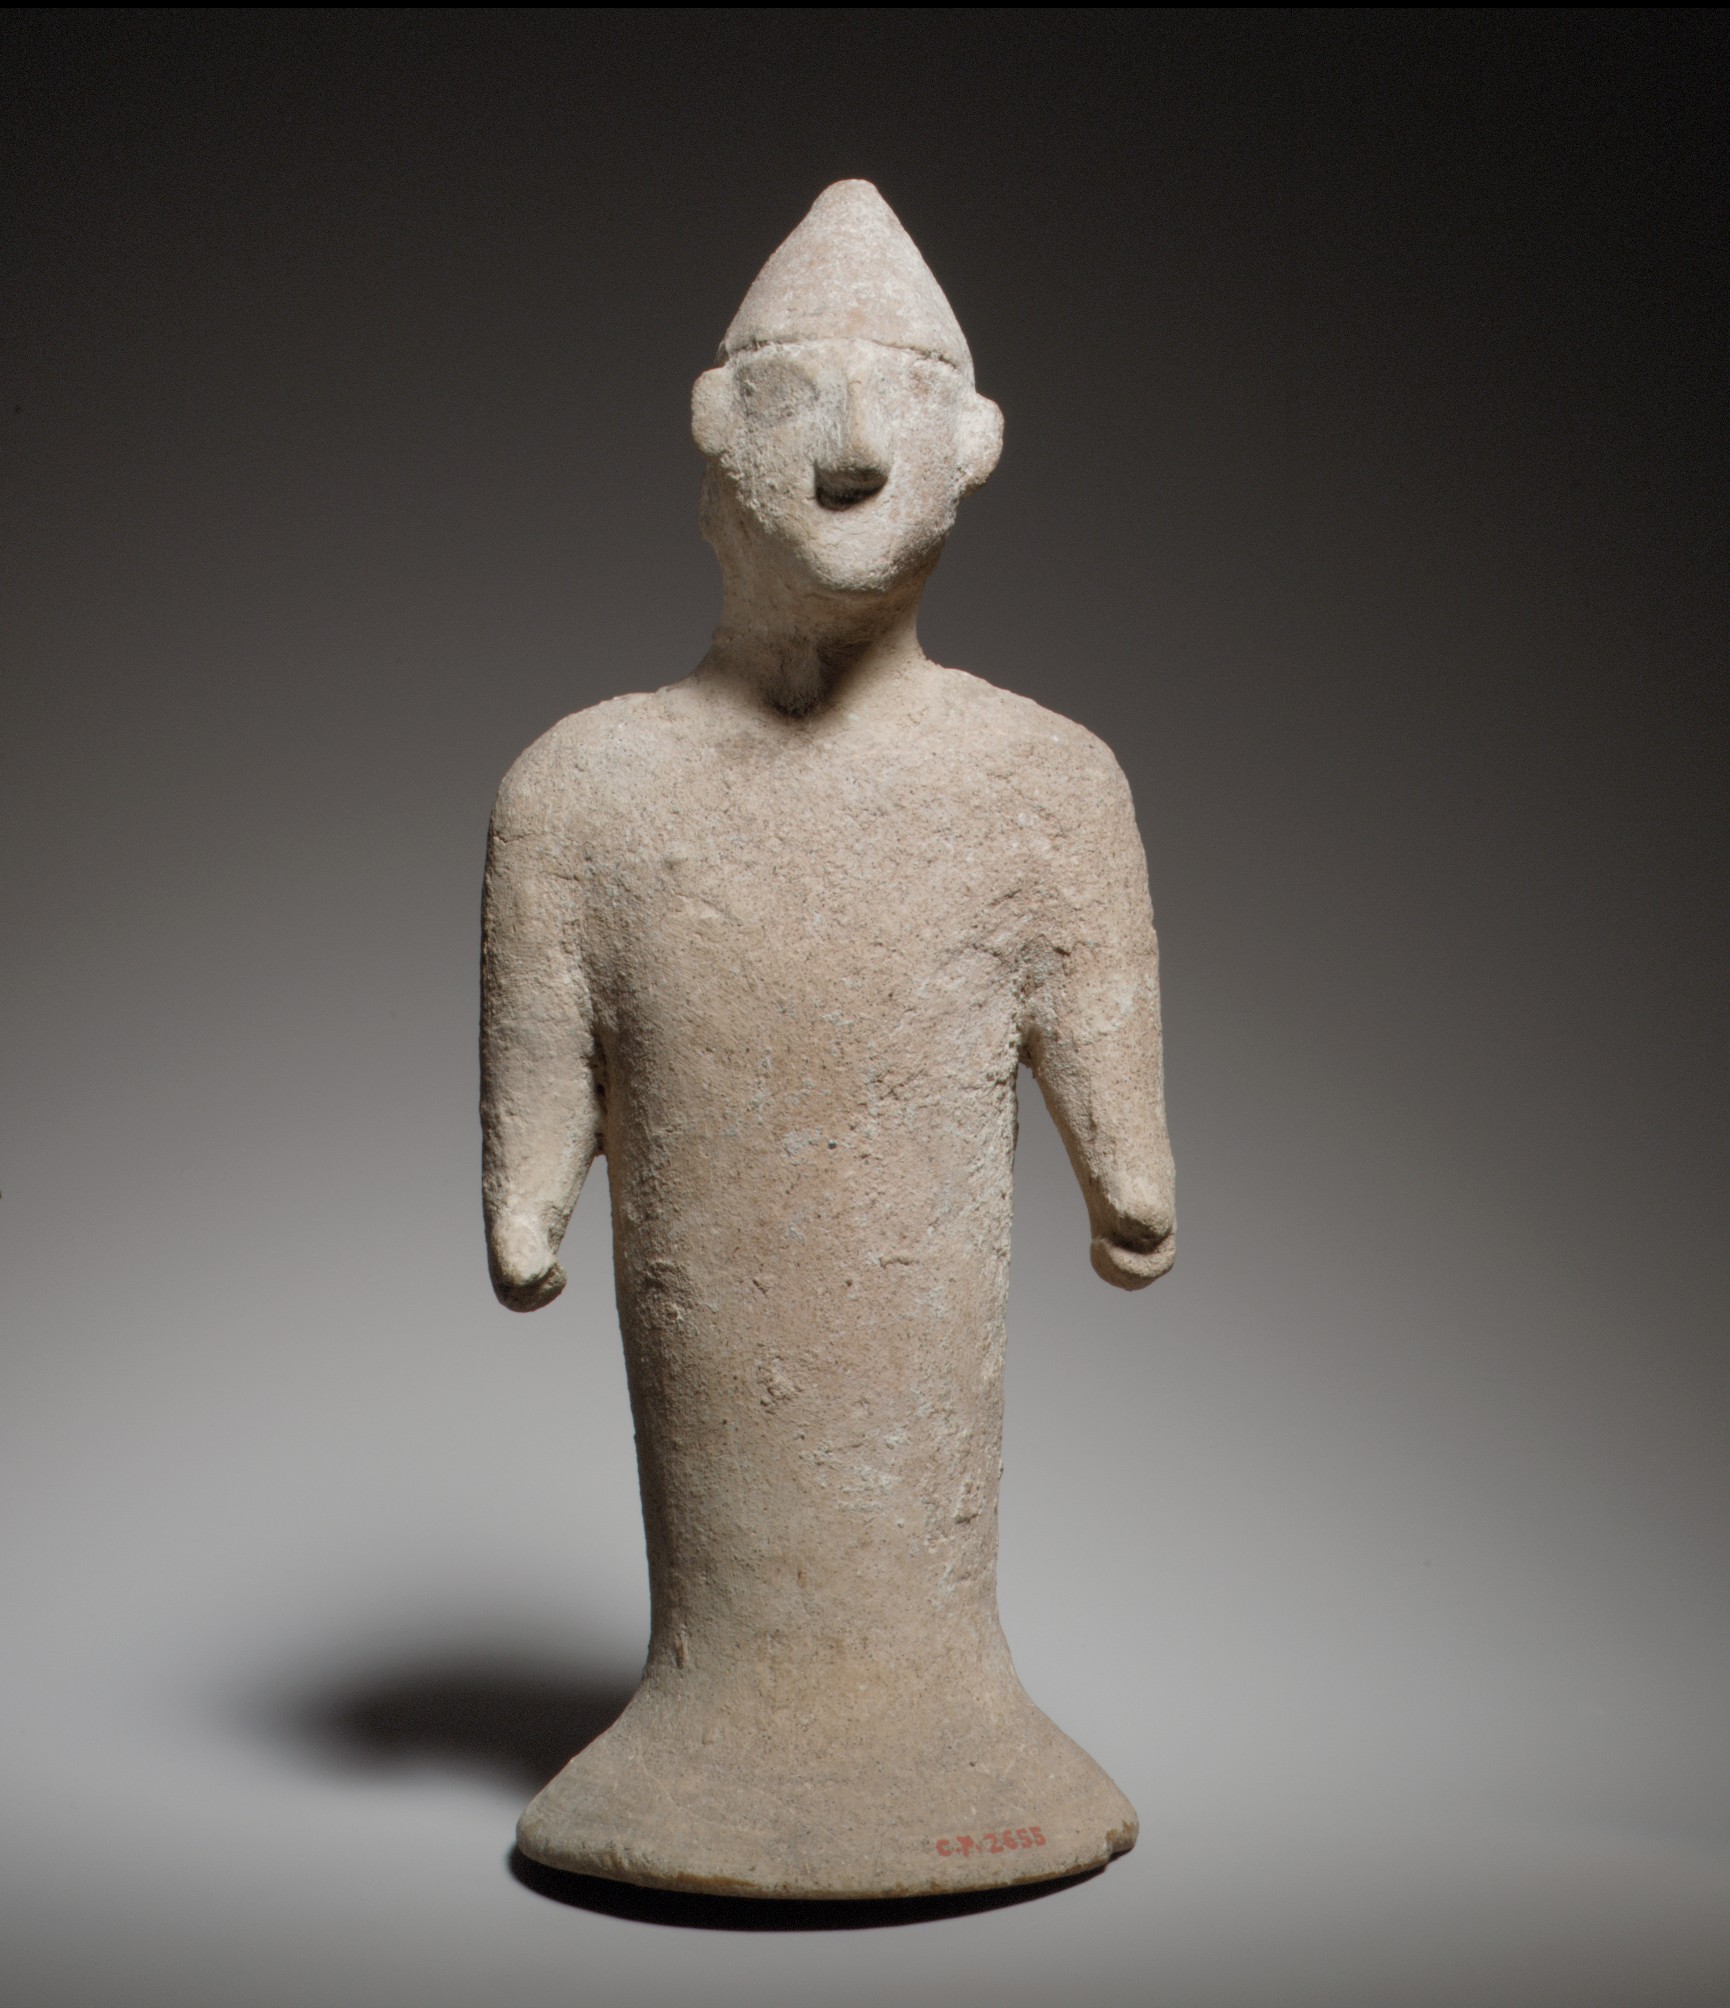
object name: statuette of a man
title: Terracotta figure of a man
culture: cypriot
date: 750-600 BCE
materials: terracotta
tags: men